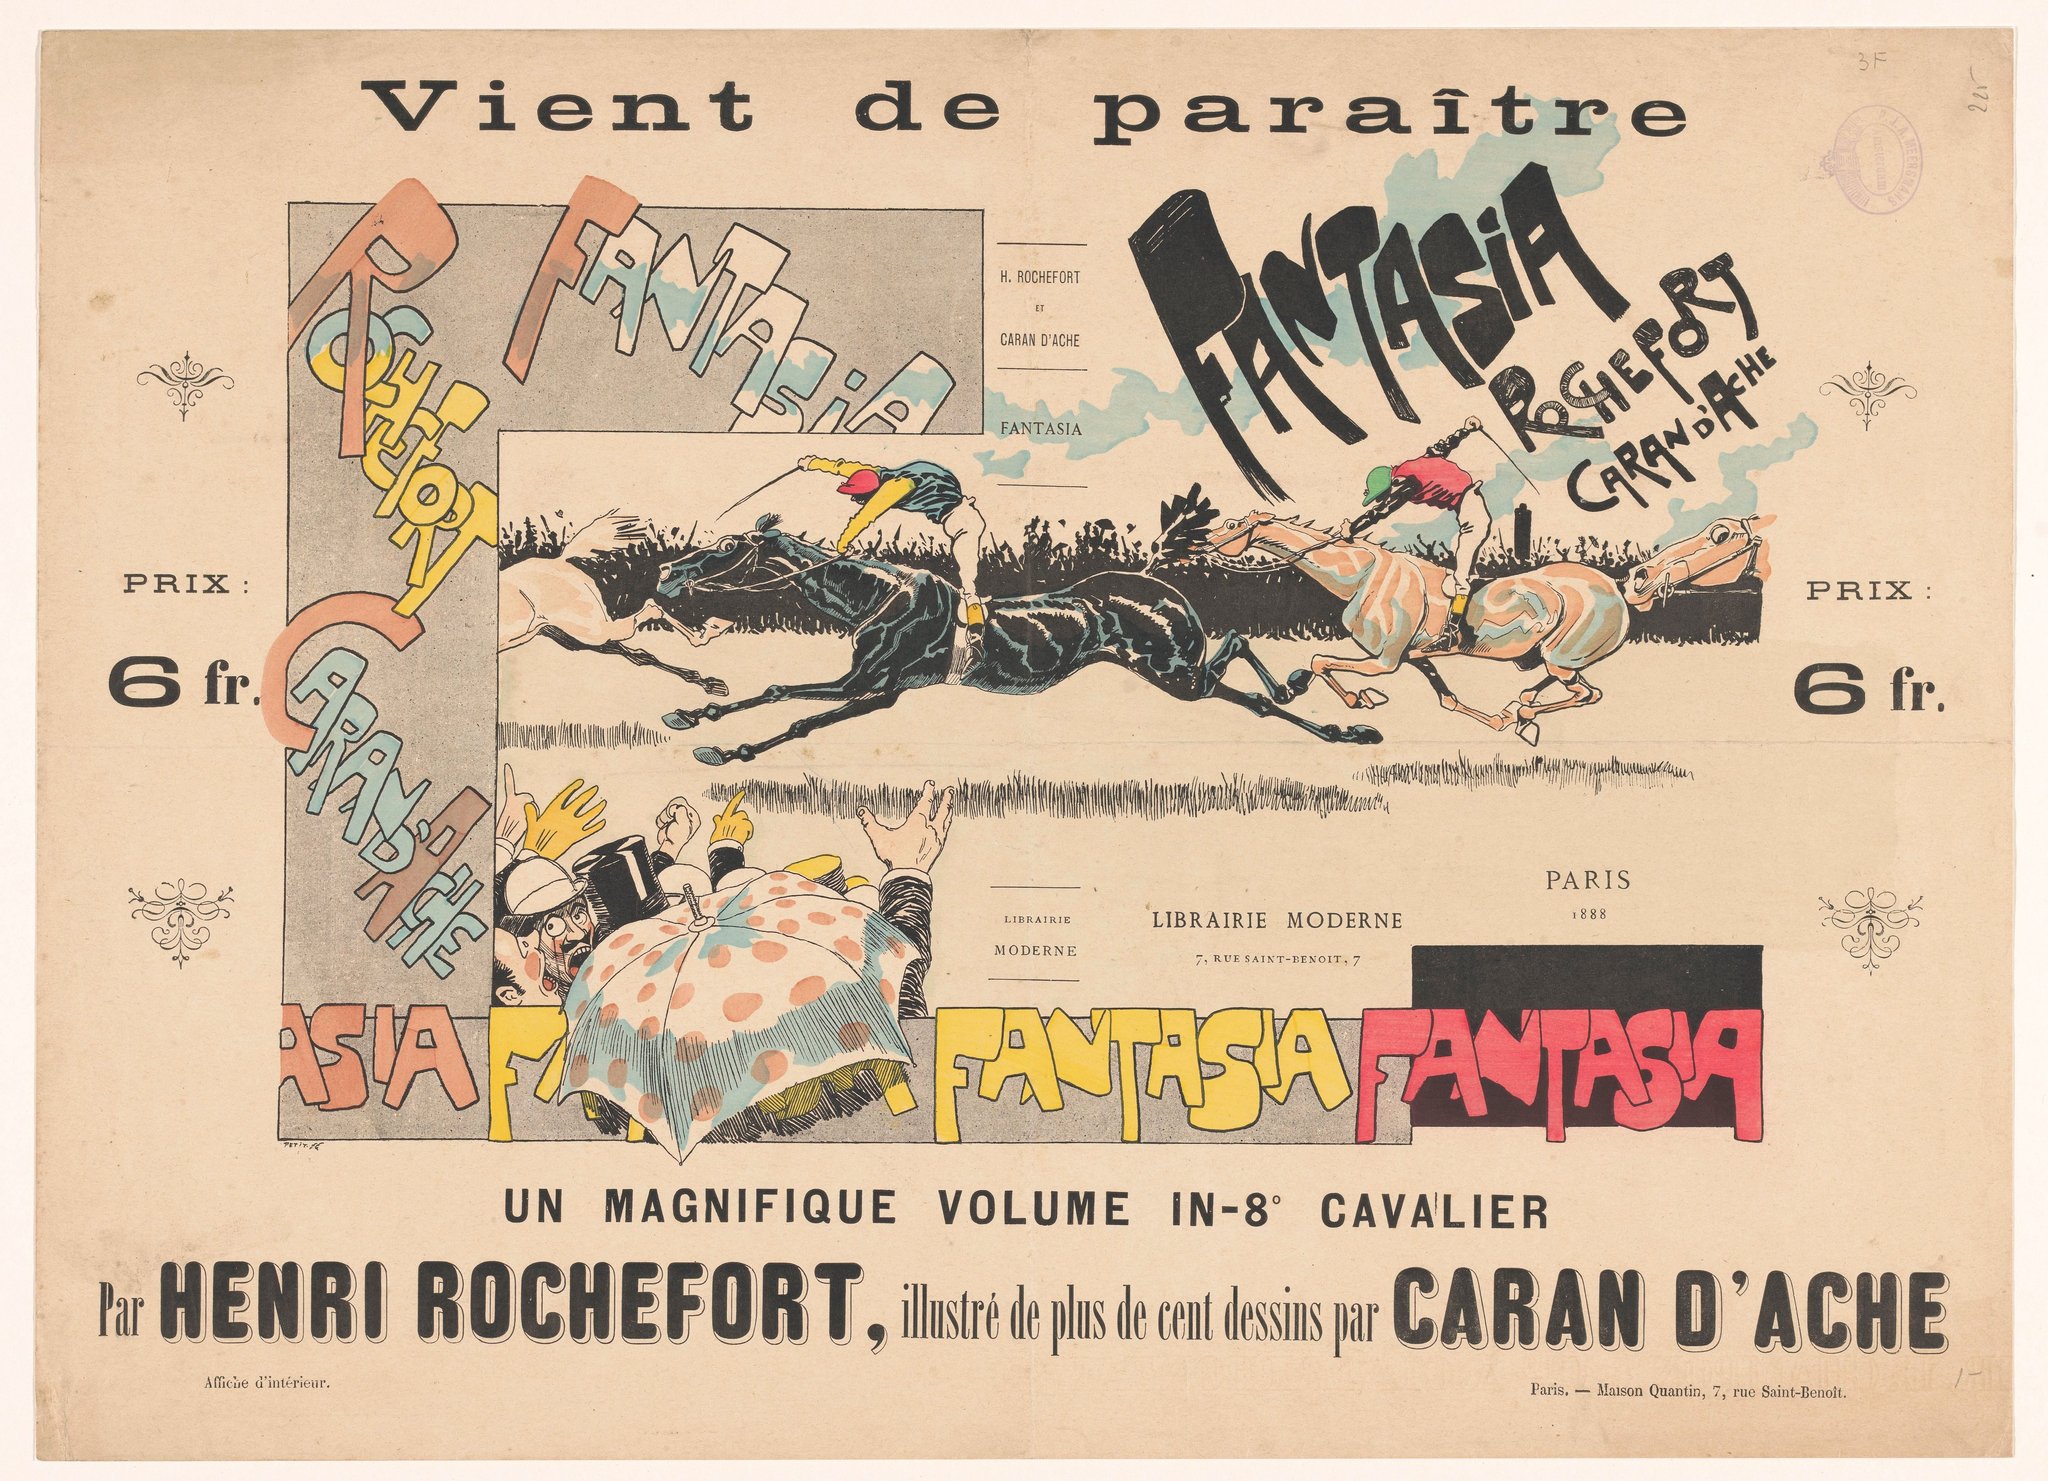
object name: reclamebiljet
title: Reclamebiljet voor Fantasia door Henri Rochefort met illustraties door Caran d'Ache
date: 1888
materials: paper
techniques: lithograph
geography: paris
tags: horse-racing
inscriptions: collector's mark: Lugt 2228, collector's mark: ‘P.J.A. Meersmans Amsterdam’, collector's mark: Lugt 4779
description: Paardenrennen met publiek op de voor- en achtergrond.